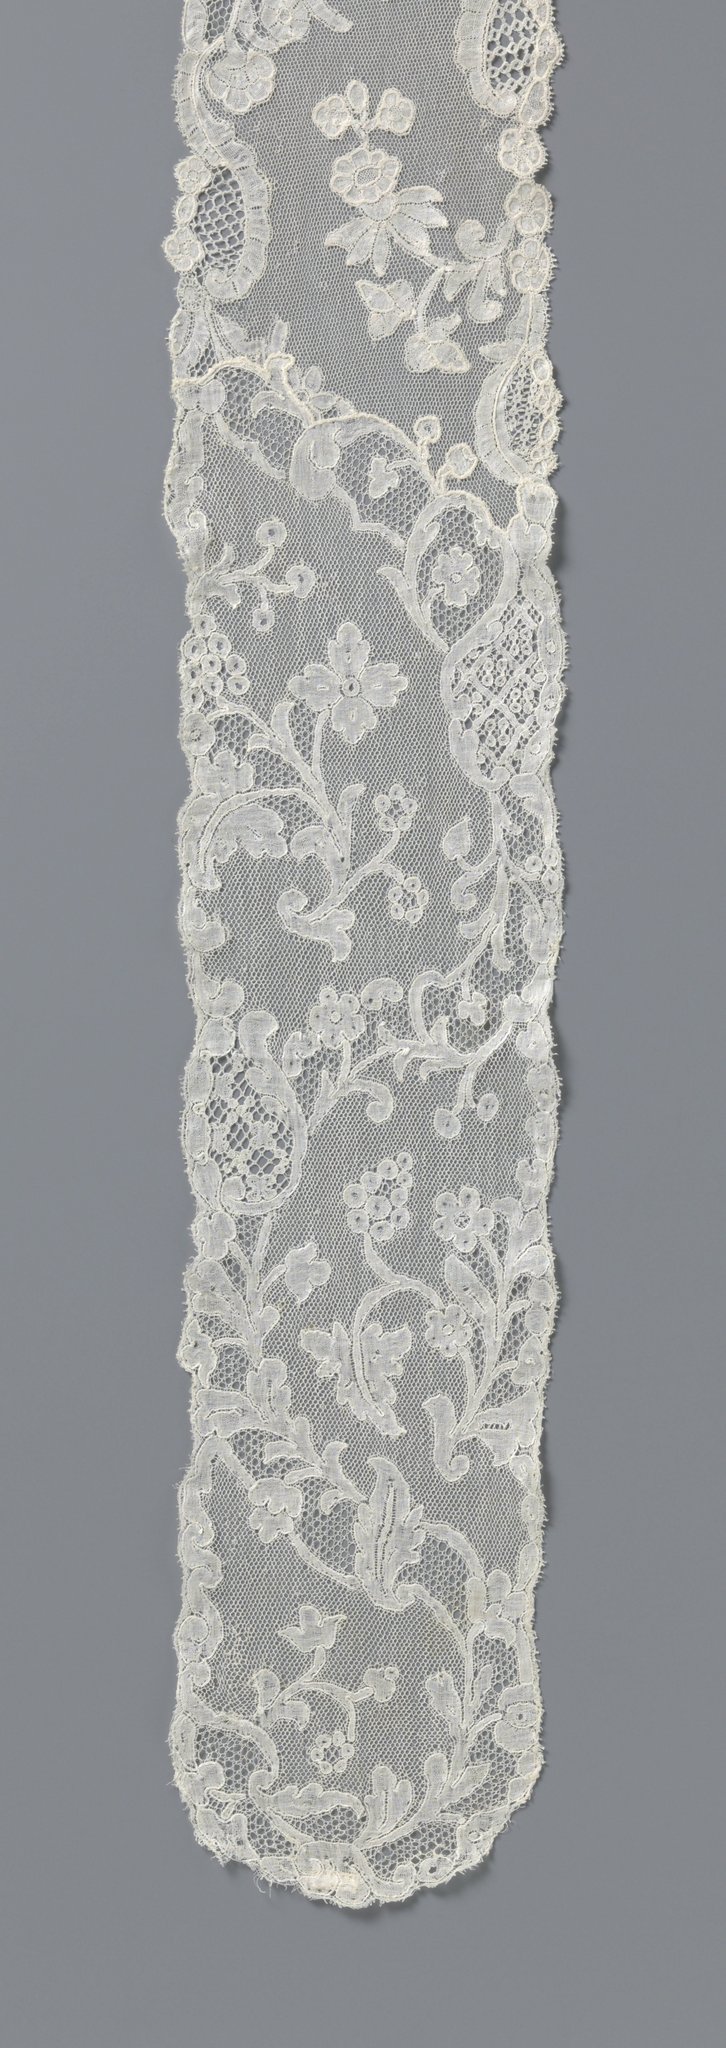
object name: lappet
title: Mutsenslip van kloskant met rivières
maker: Anonymous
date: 1750-1760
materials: linen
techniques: lace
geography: brussels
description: Mutsenslip van naturelkleurige kloskant: Mechelse kant. Rivière met als begrenzing twee blad- en bloemstengels, terwijl een druiventros op de tussenliggende velden staat. De schulpen zijn vlak en vertonen met rasterwerk gevulde medaillons. Bij vergissing is deze Mechelse mutsenslip aan een Brusselse mutsenslip (BK-BR-J-175-A) gezet, terwijl de bijpassende tweede Brusselse mutsenslip (BK-BR-J-177) afzonderlijk bleef.